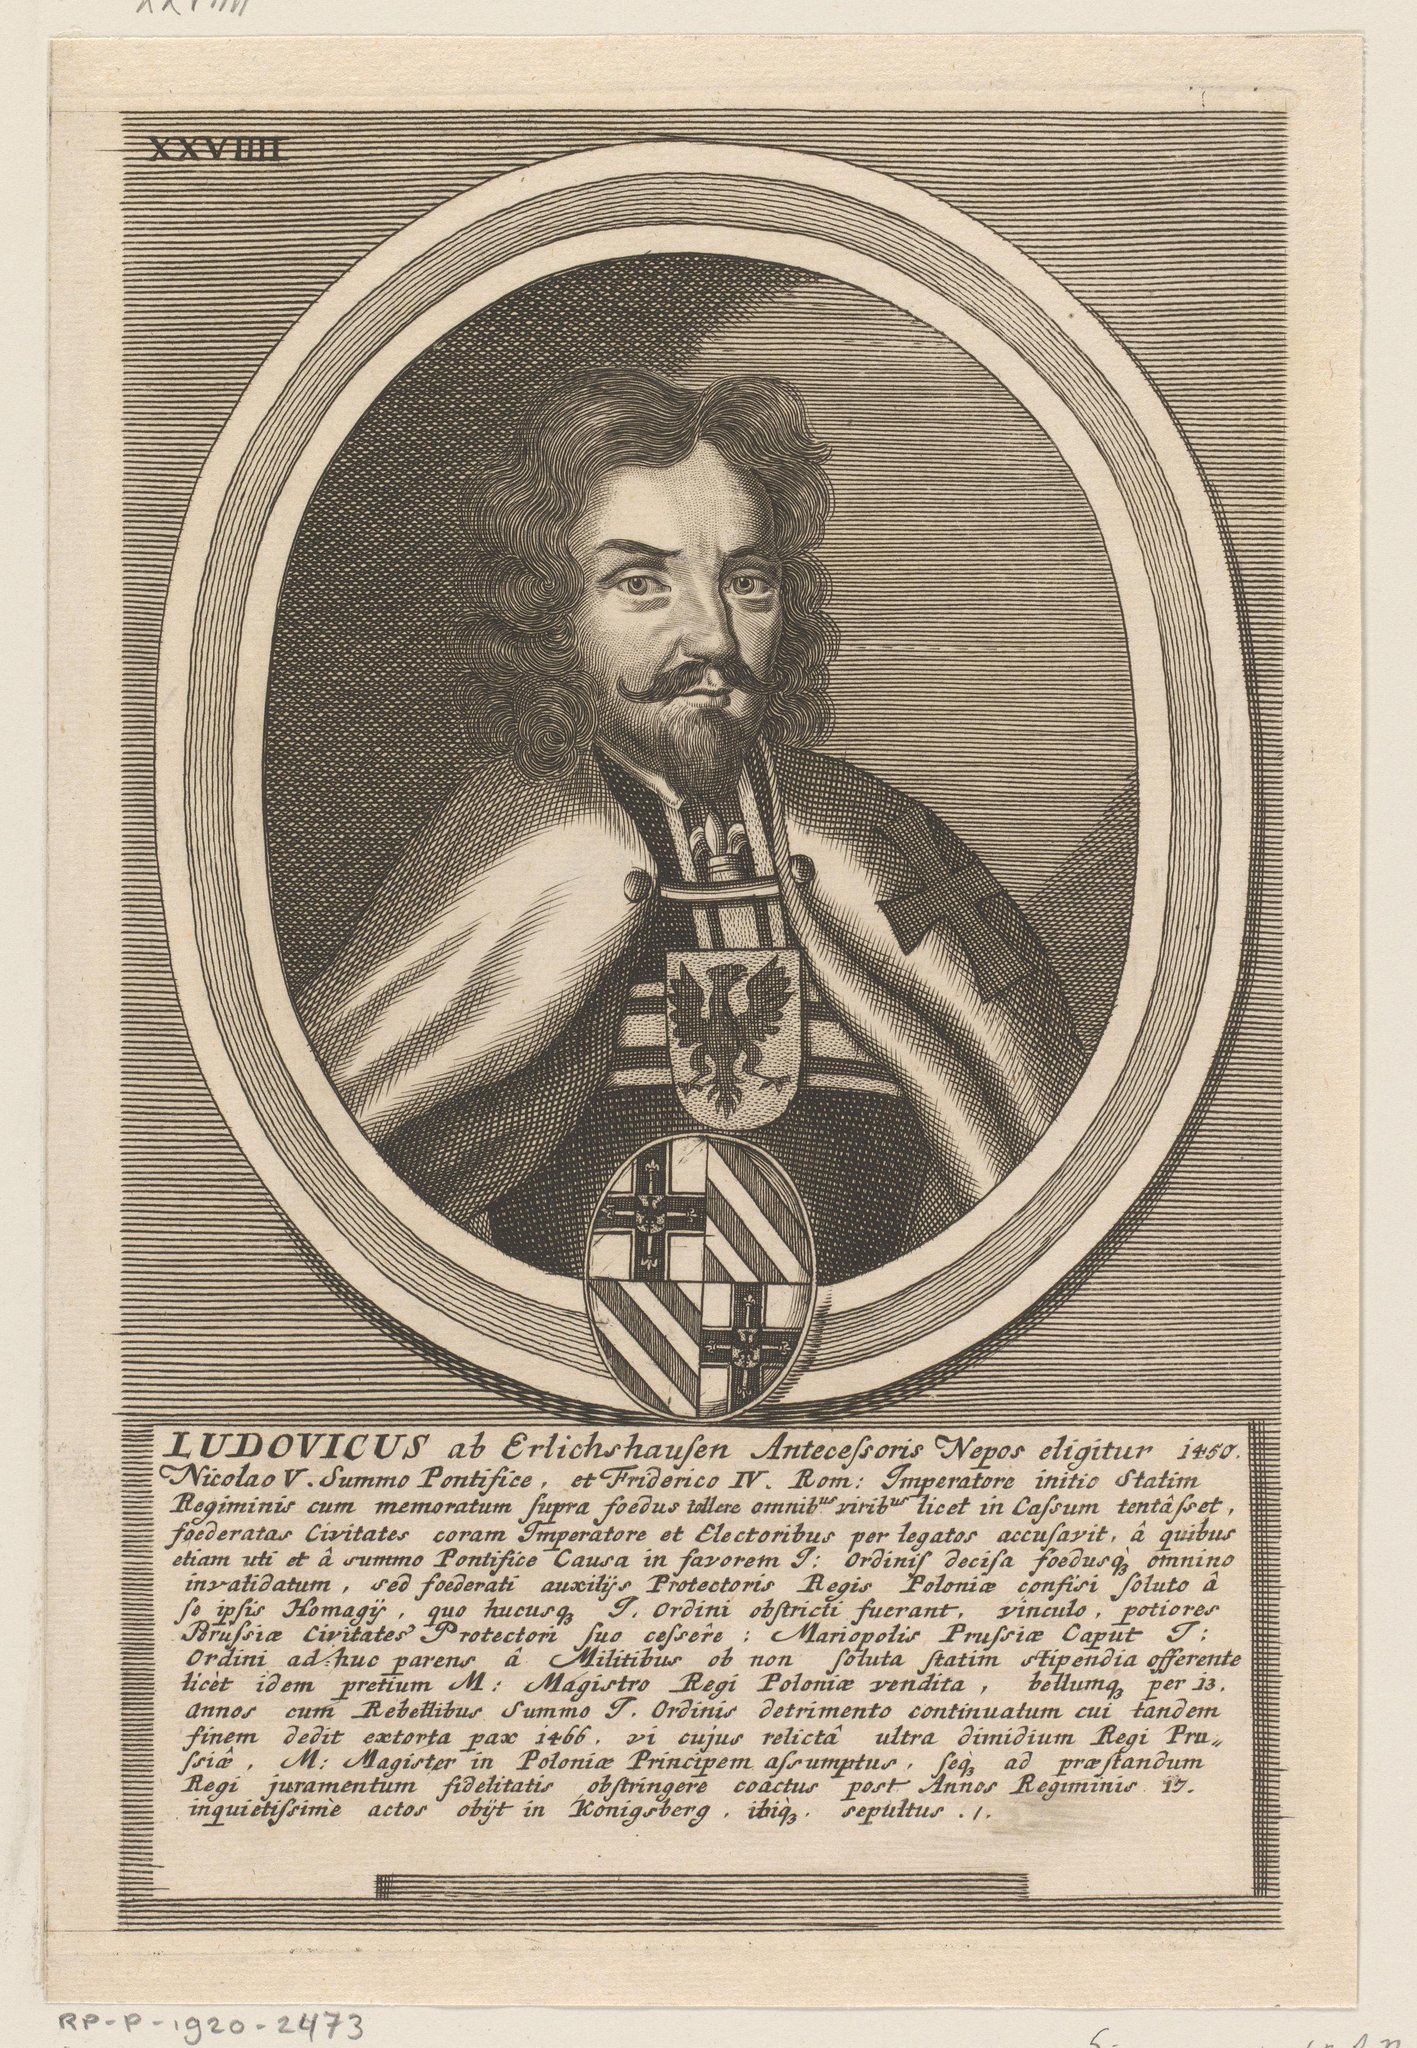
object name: print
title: Ludovicus ab Erlichshausen (...)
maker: johann salver (i)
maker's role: print maker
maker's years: 1670-1738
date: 1720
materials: paper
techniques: engraving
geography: würzburg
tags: knighthood order: teutonic order - insignia of a knighthood order, e.g.: badge, chain (with name of order), historical persons, armorial bearing, heraldry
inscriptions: collector's mark: Lugt 2228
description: Prent uit: [Salver, Johann]. De origine, secundis et adversis successibus, nec non de statu moderno inclyti ordinis equestris hospitalis b.m.v. Teutonicorum in Jerusalem. Würzburg: Johann Salver, [ca. 1720].